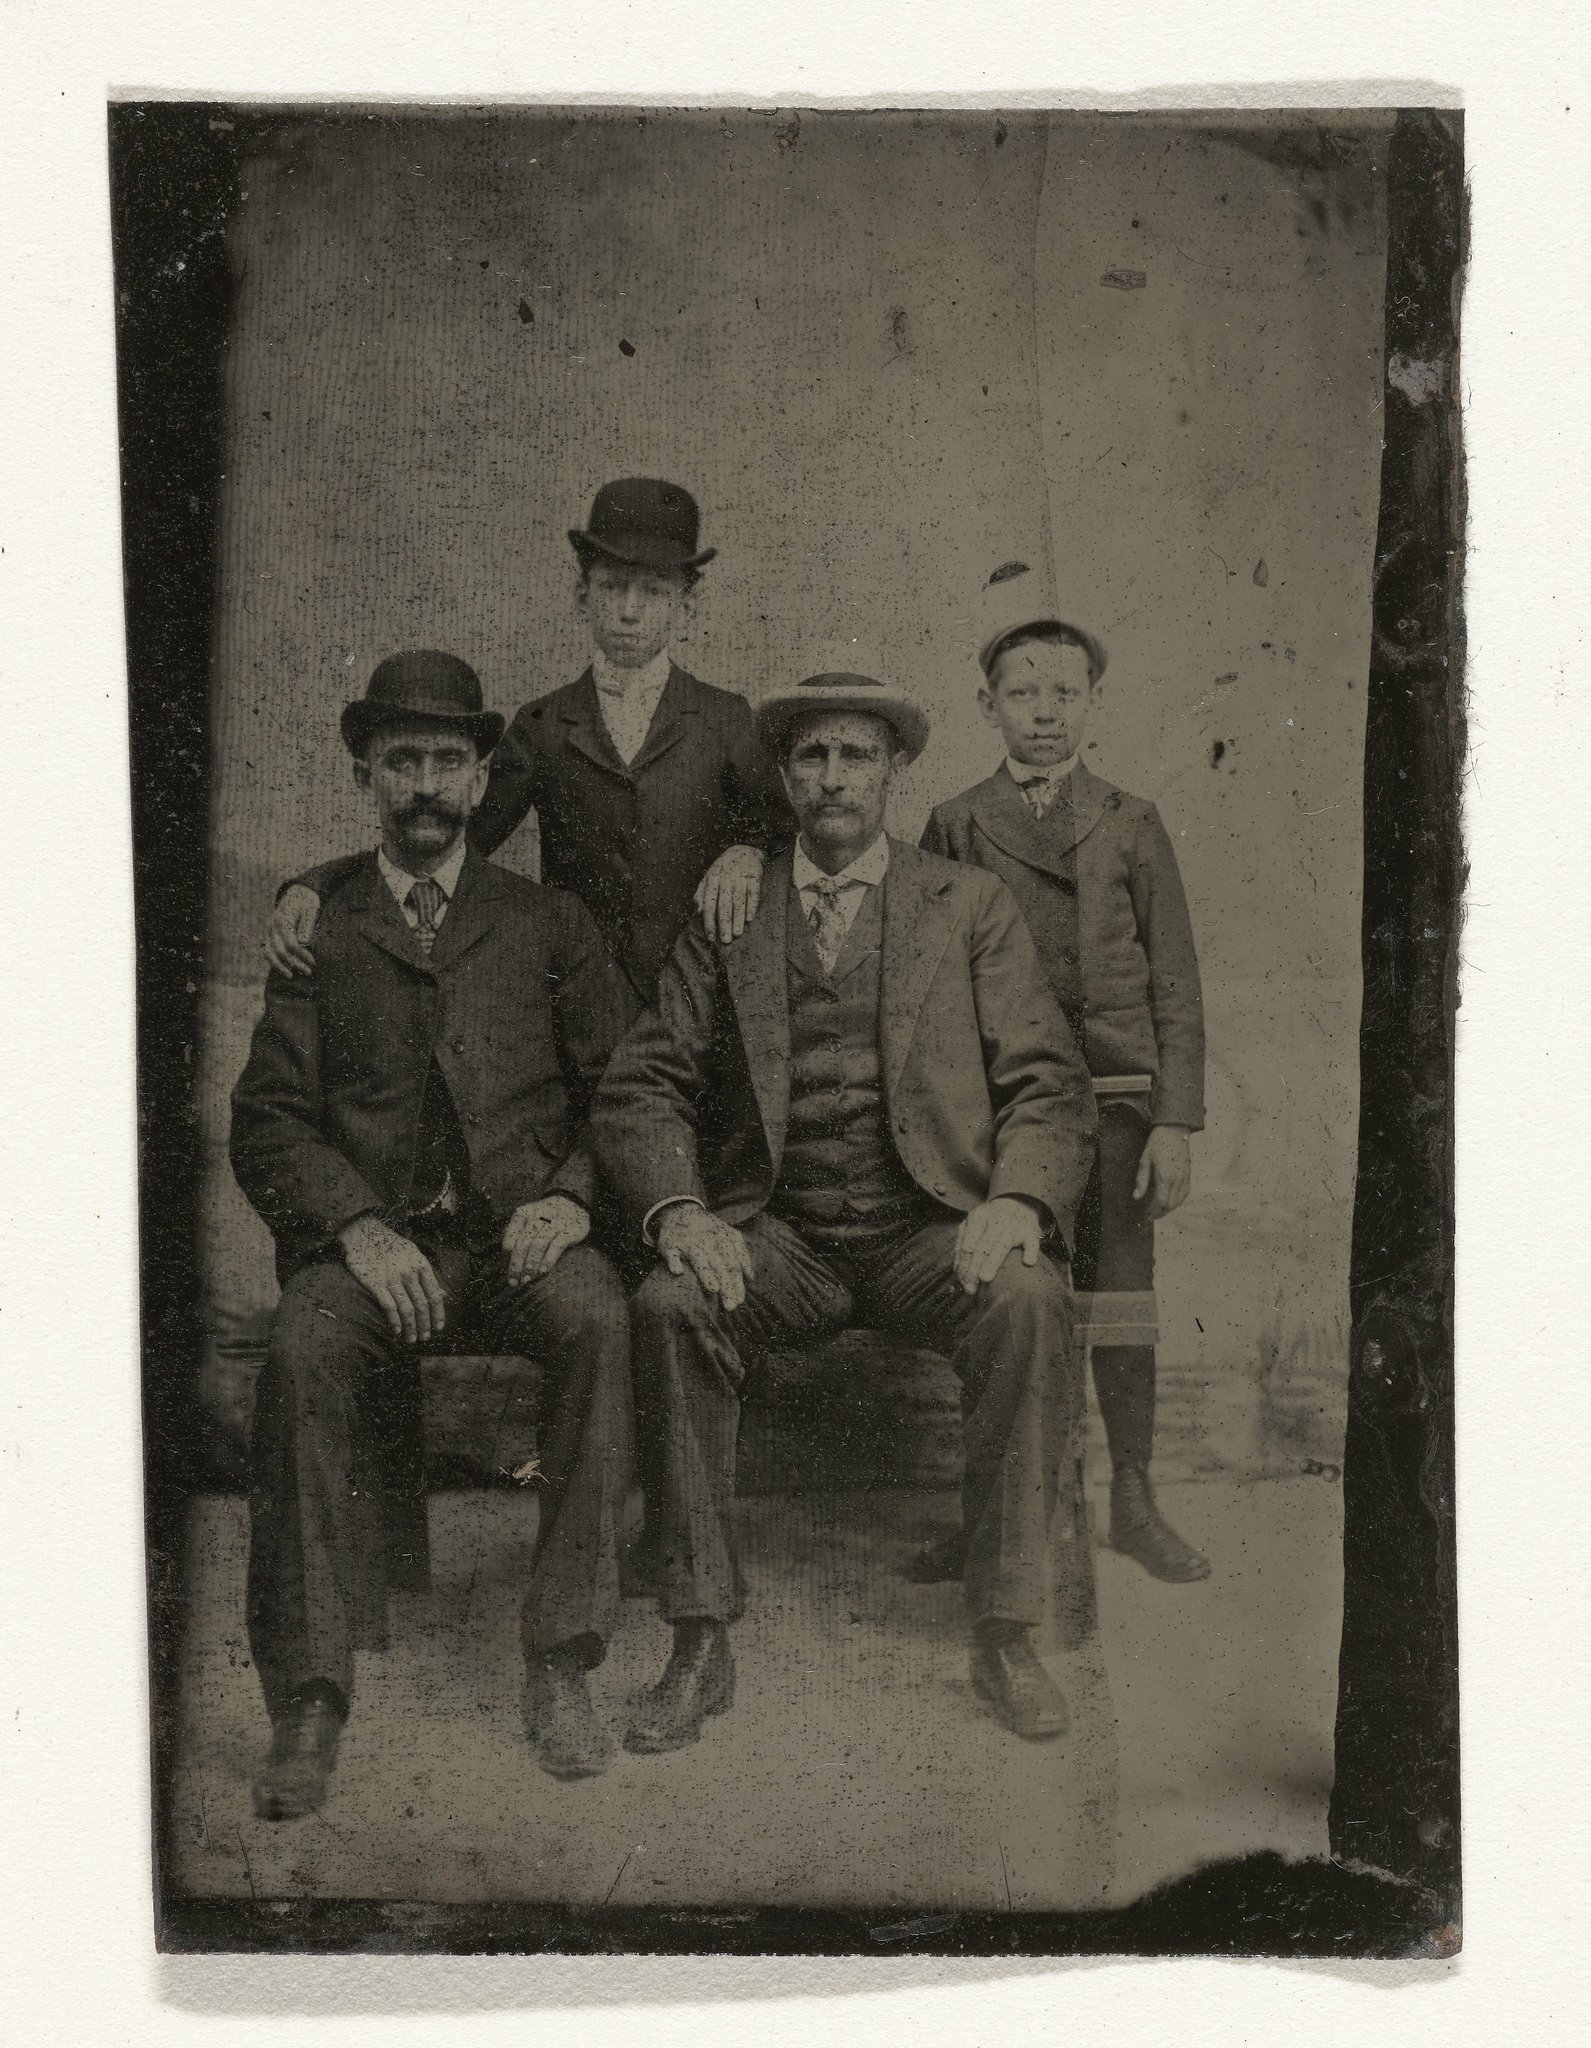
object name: photograph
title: Portret van twee mannen en twee jongens, staand en zittend voor een geschilderd achtergronddoek (vijver?)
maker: Anonymous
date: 1880-1900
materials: metal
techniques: ferrotyping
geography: united states